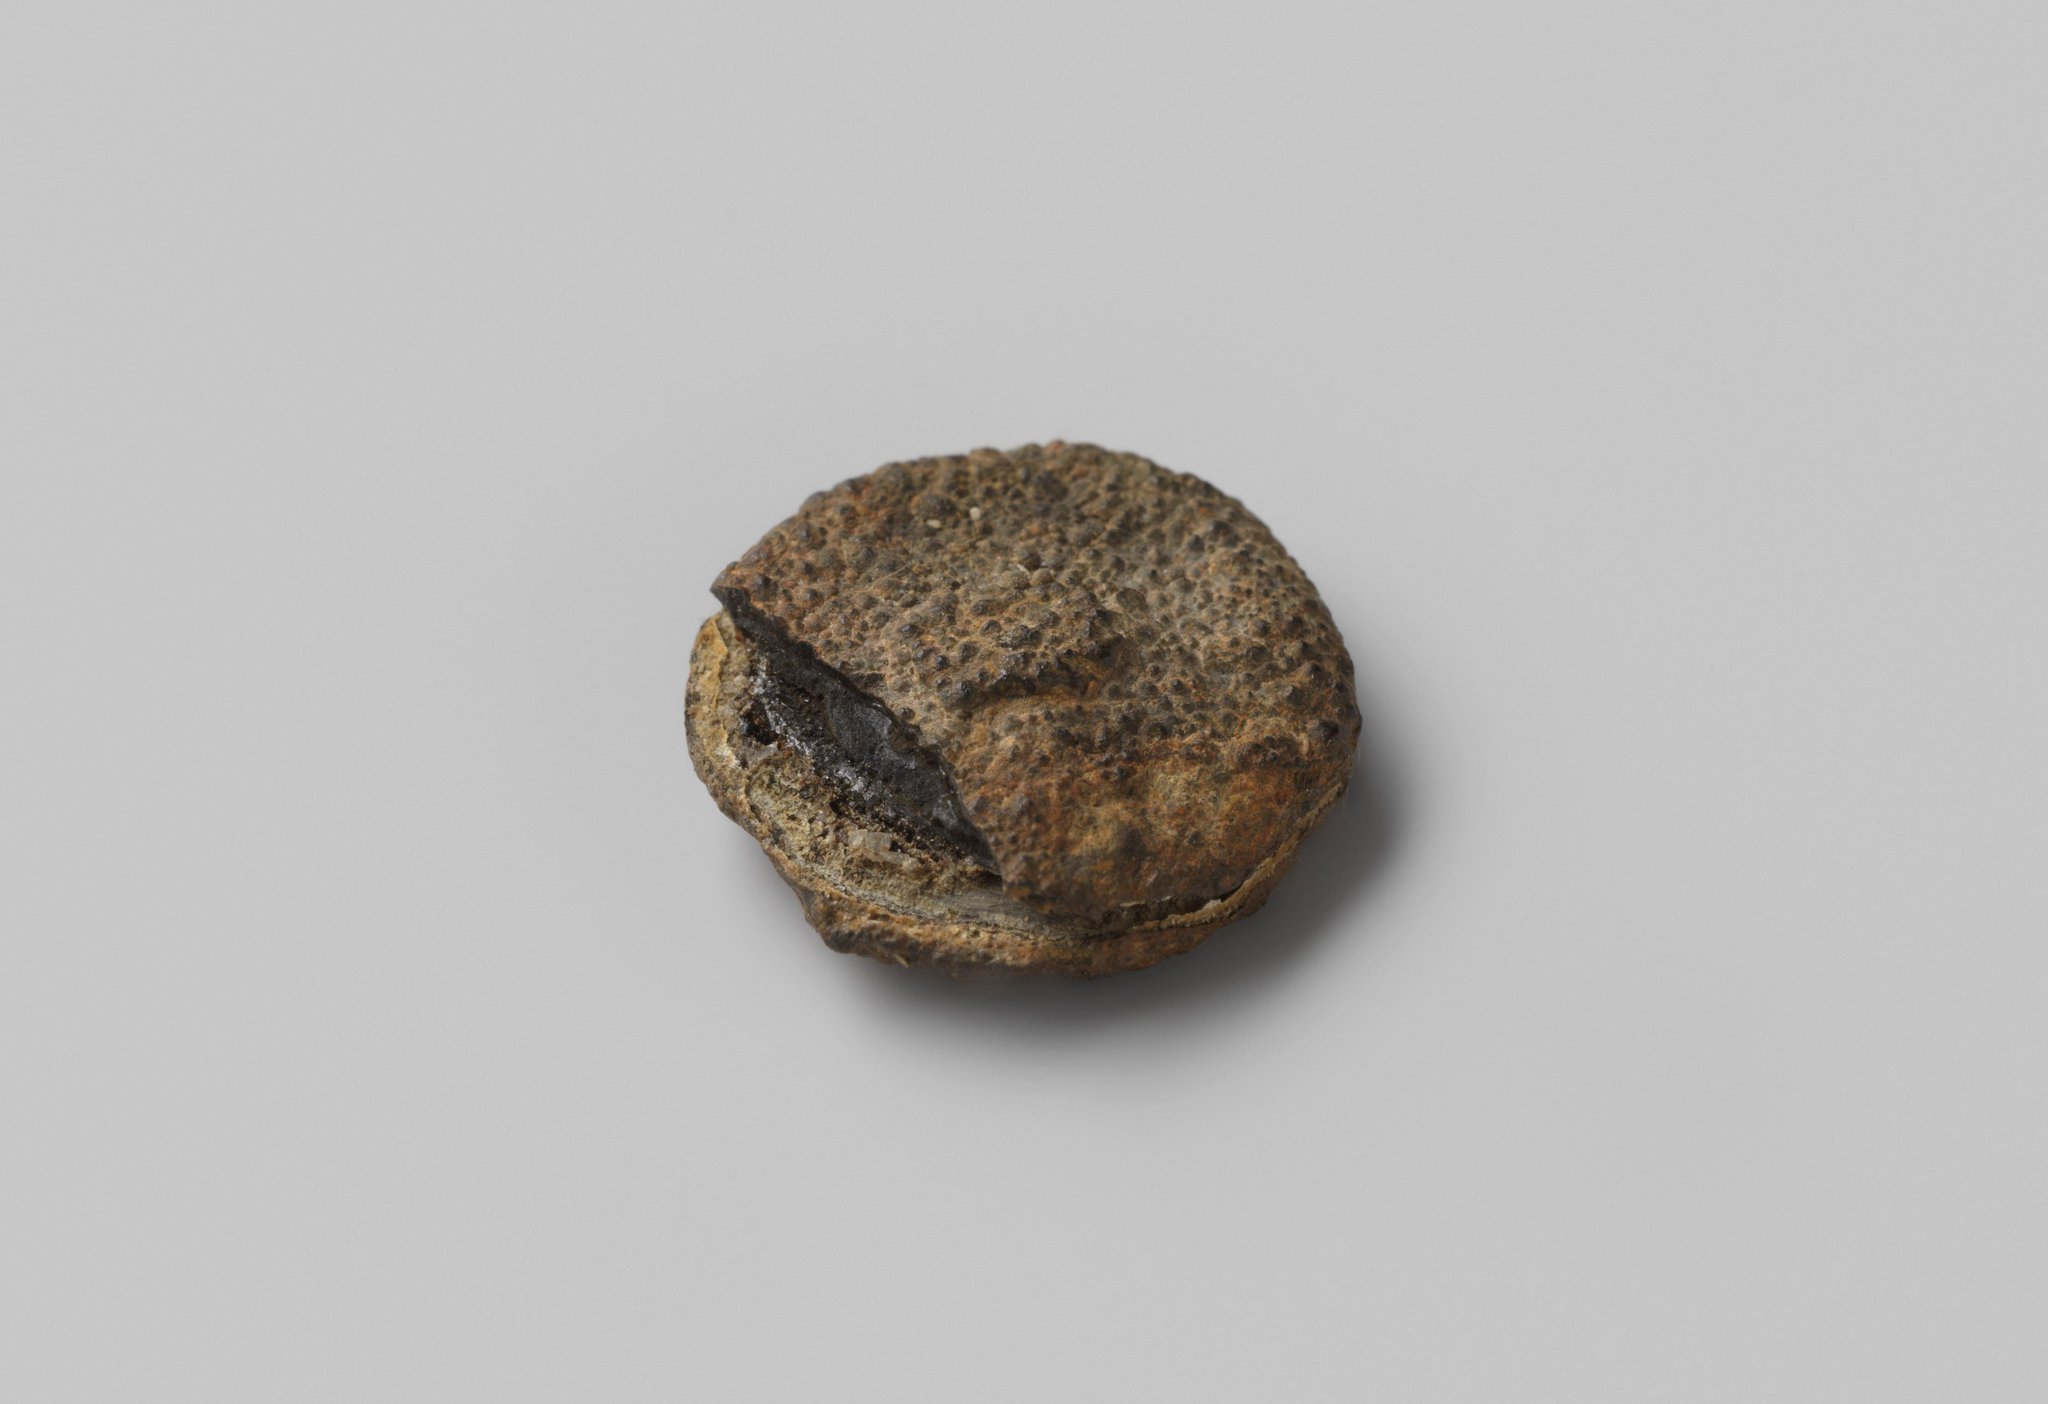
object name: fragment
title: Schijfvormig fragment uit het wrak van de Oost-Indiëvaarder Hollandia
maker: Anonymous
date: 1700-1743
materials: lead, tin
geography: netherlands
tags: verenigde oostindische compagnie, hollandia (schip), annet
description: Varied parts or fragments, discs and disc-shaped fragments; corroded, consisting of 2 circular, flat, discs, with central rivet.